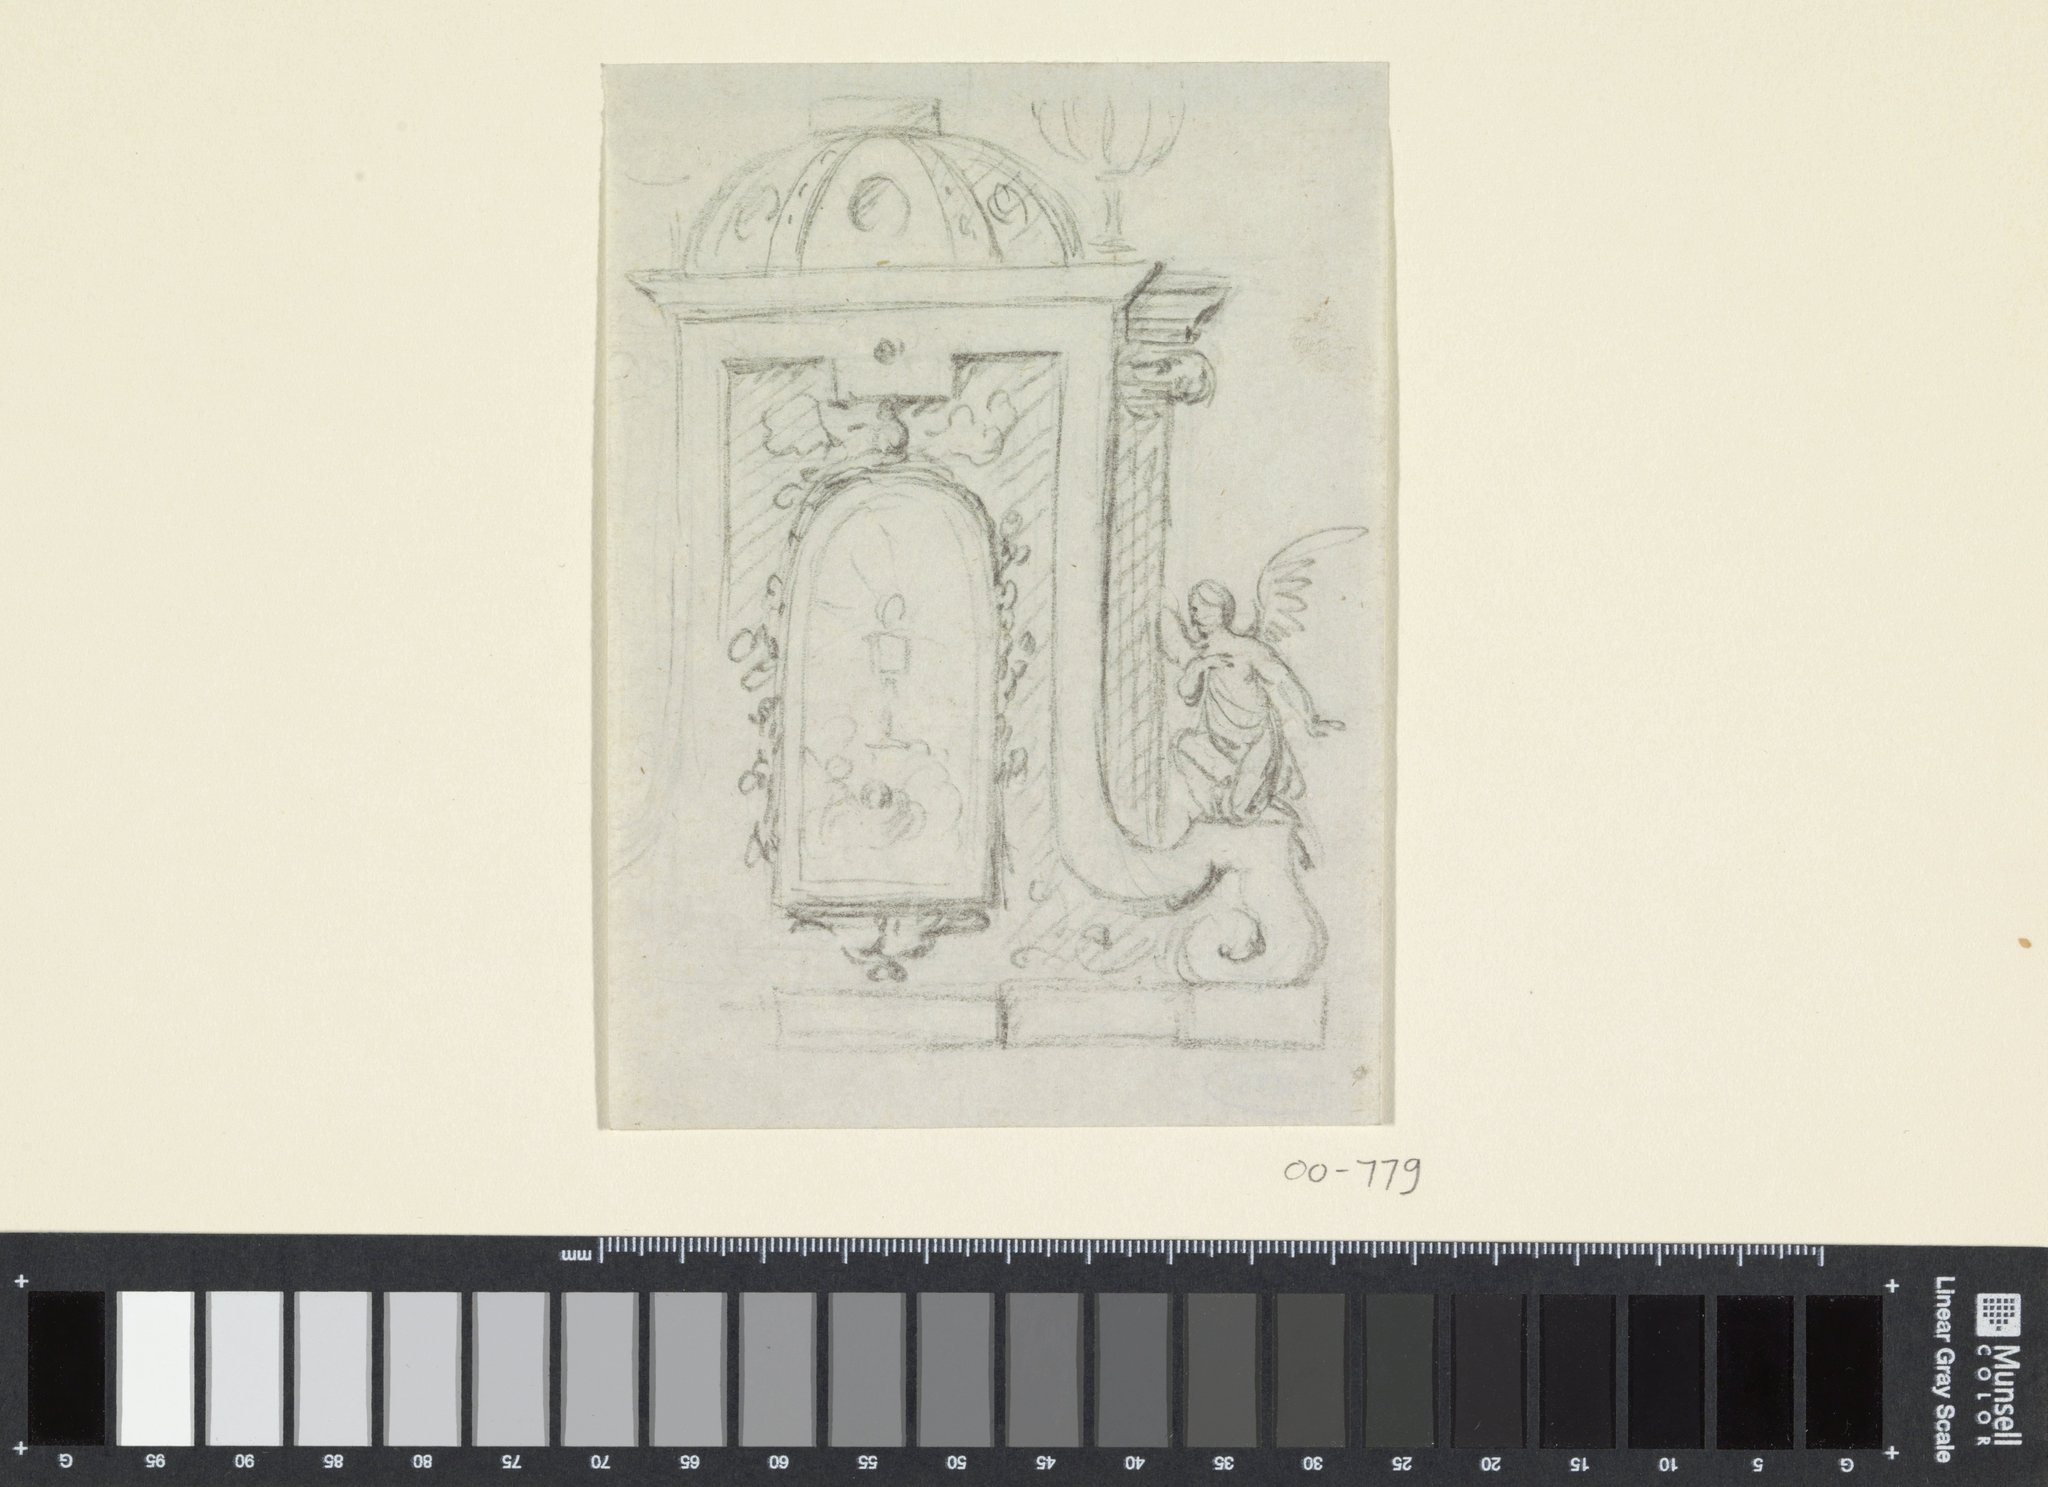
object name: drawing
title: Tabernakel met engel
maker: Anonymous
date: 1750-1800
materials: chalk, paper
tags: tabernacle ~ altar, angels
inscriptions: collector's mark: Lugt 2228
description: Ontwerp voor een tabernakel met een kelk met hostie en rechts een engel.